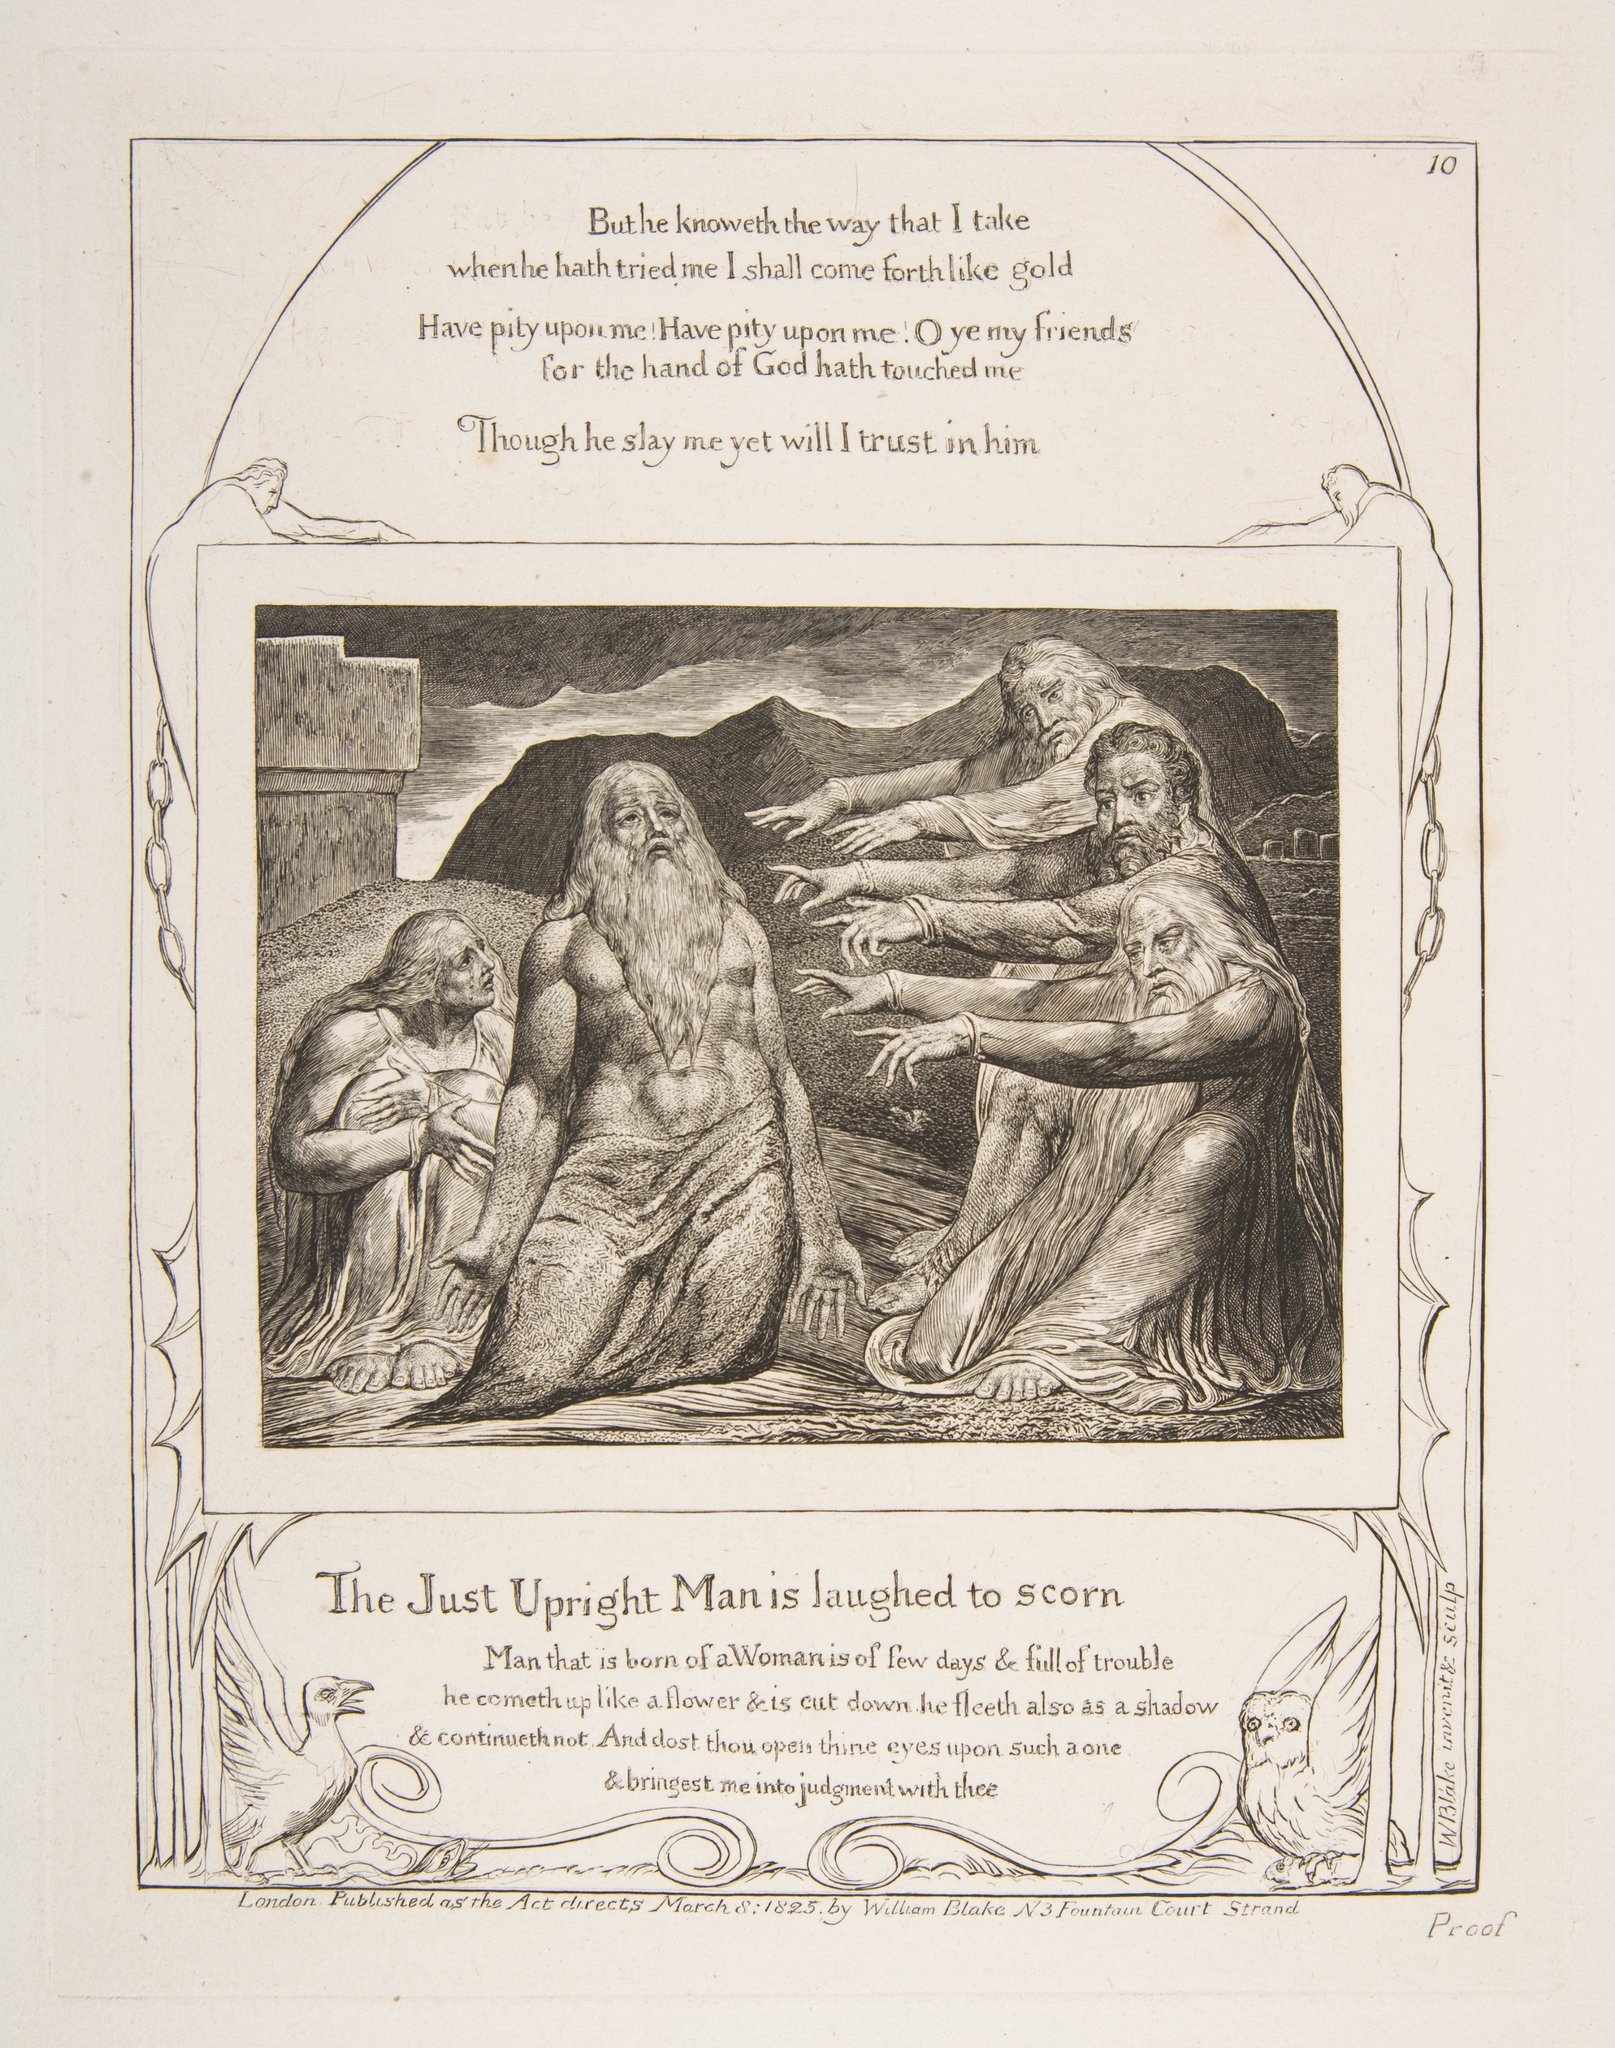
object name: print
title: Job rebuked by his Friends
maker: william blake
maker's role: artist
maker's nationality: british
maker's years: 1757-1827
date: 1825-1826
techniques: engraving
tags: birds,men,women,job